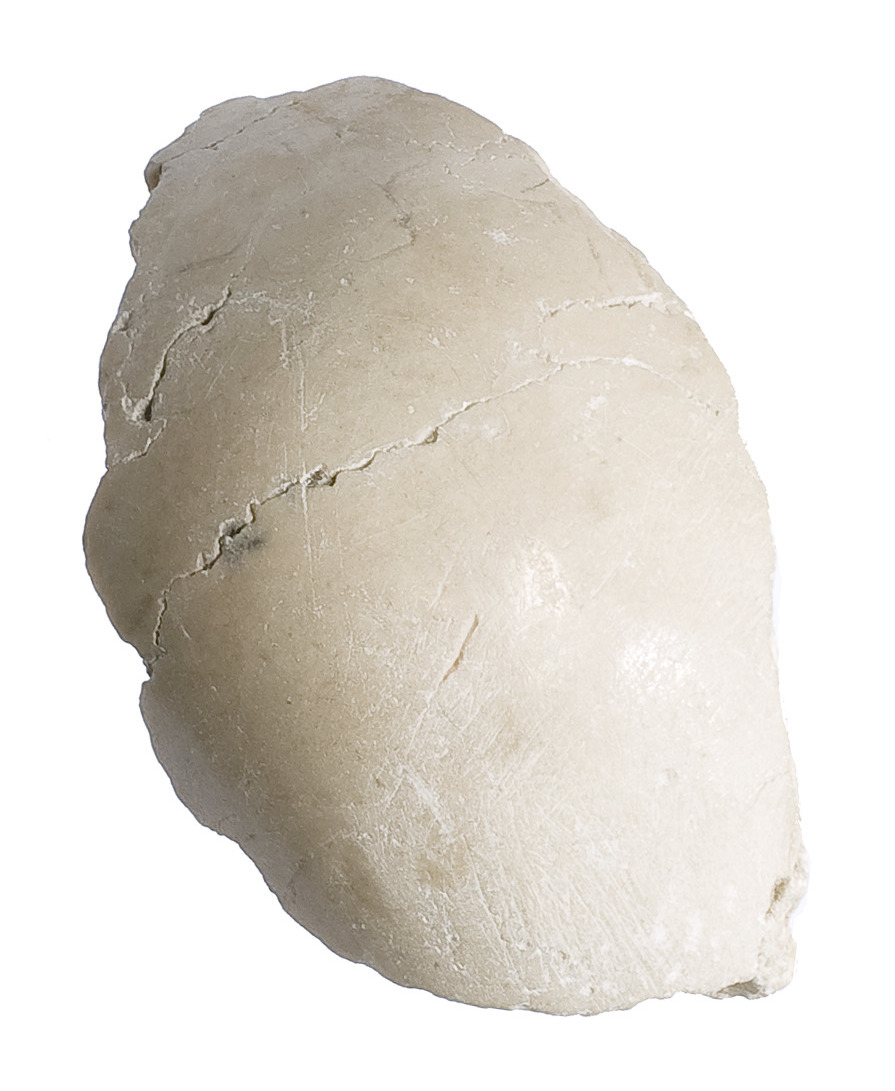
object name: elbow or shoulder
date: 1353-1336 BCE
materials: limestone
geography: egypt